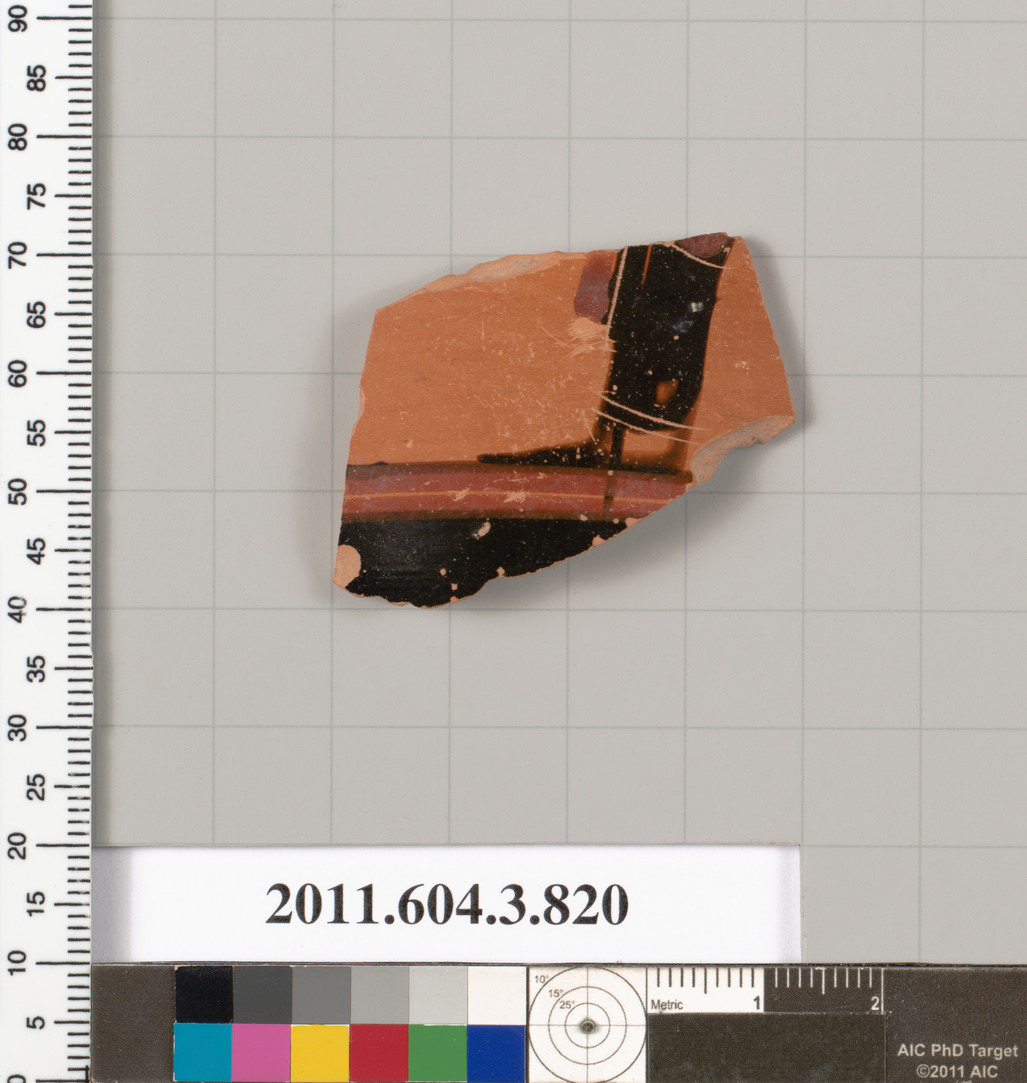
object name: lekythos fragment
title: Terracotta fragment of a lekythos (oil flask)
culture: greek, attic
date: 550-526 BCE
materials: terracotta